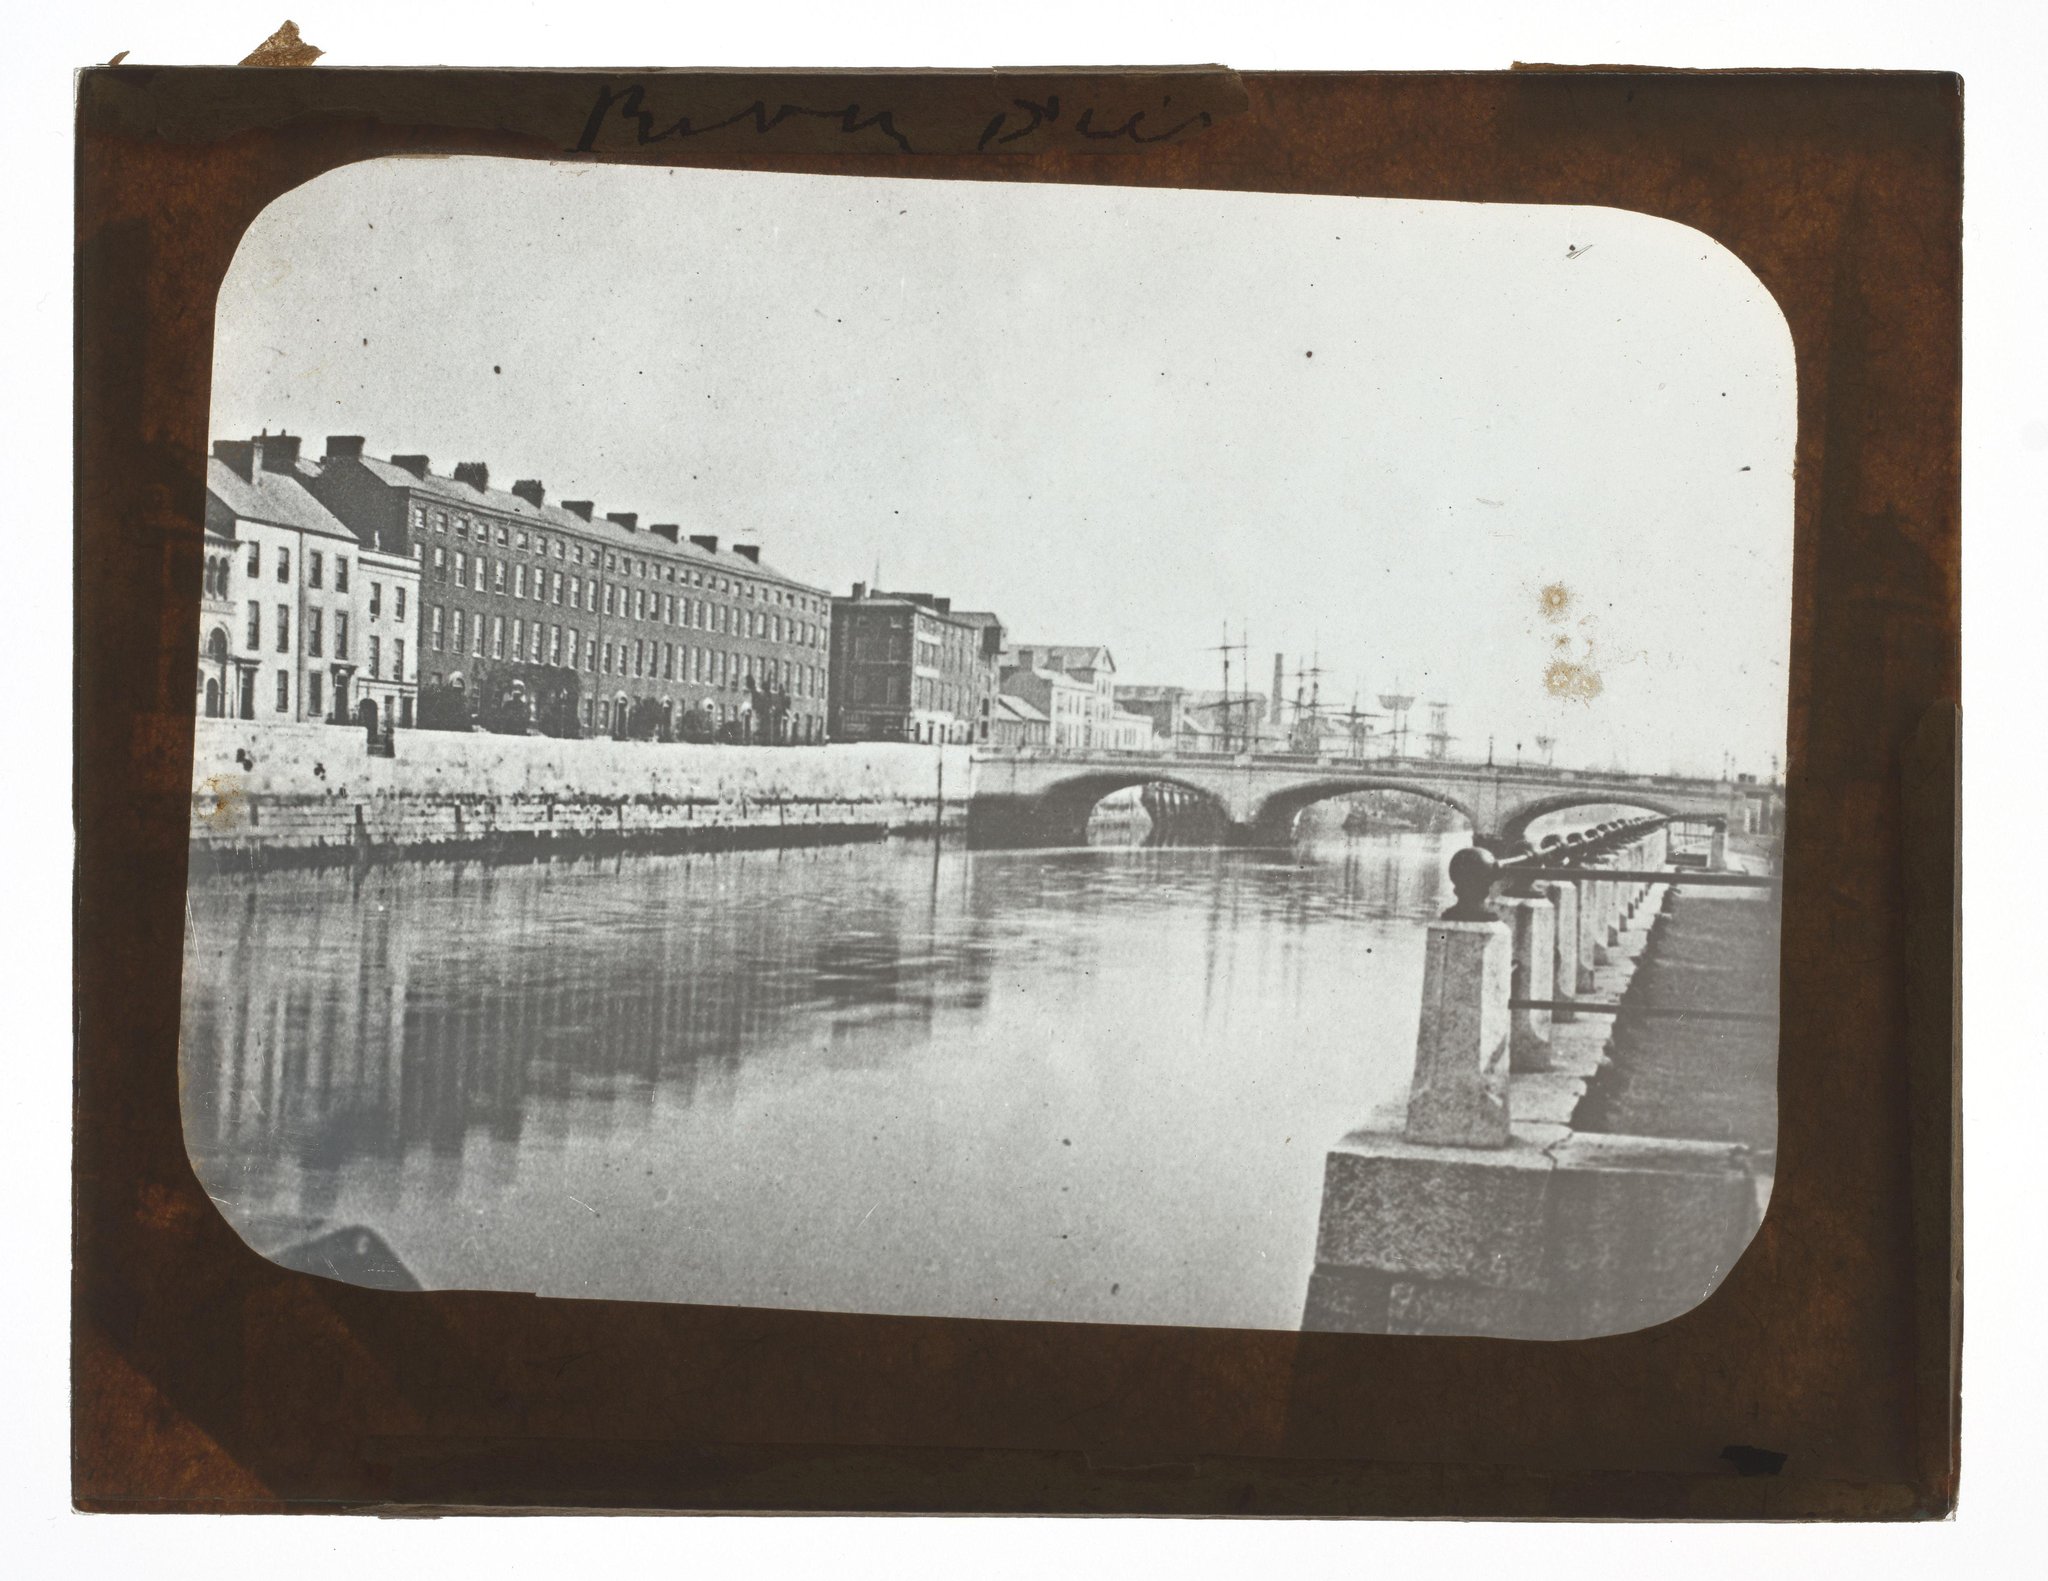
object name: lantern slide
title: Gezicht op rivier in stad, mogelijk in Engeland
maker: Anonymous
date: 1880-1910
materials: glass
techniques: gelatin silver print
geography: england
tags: bridge in city across river, canal, etc., england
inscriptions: inscription: ‘[onleesbaar]’